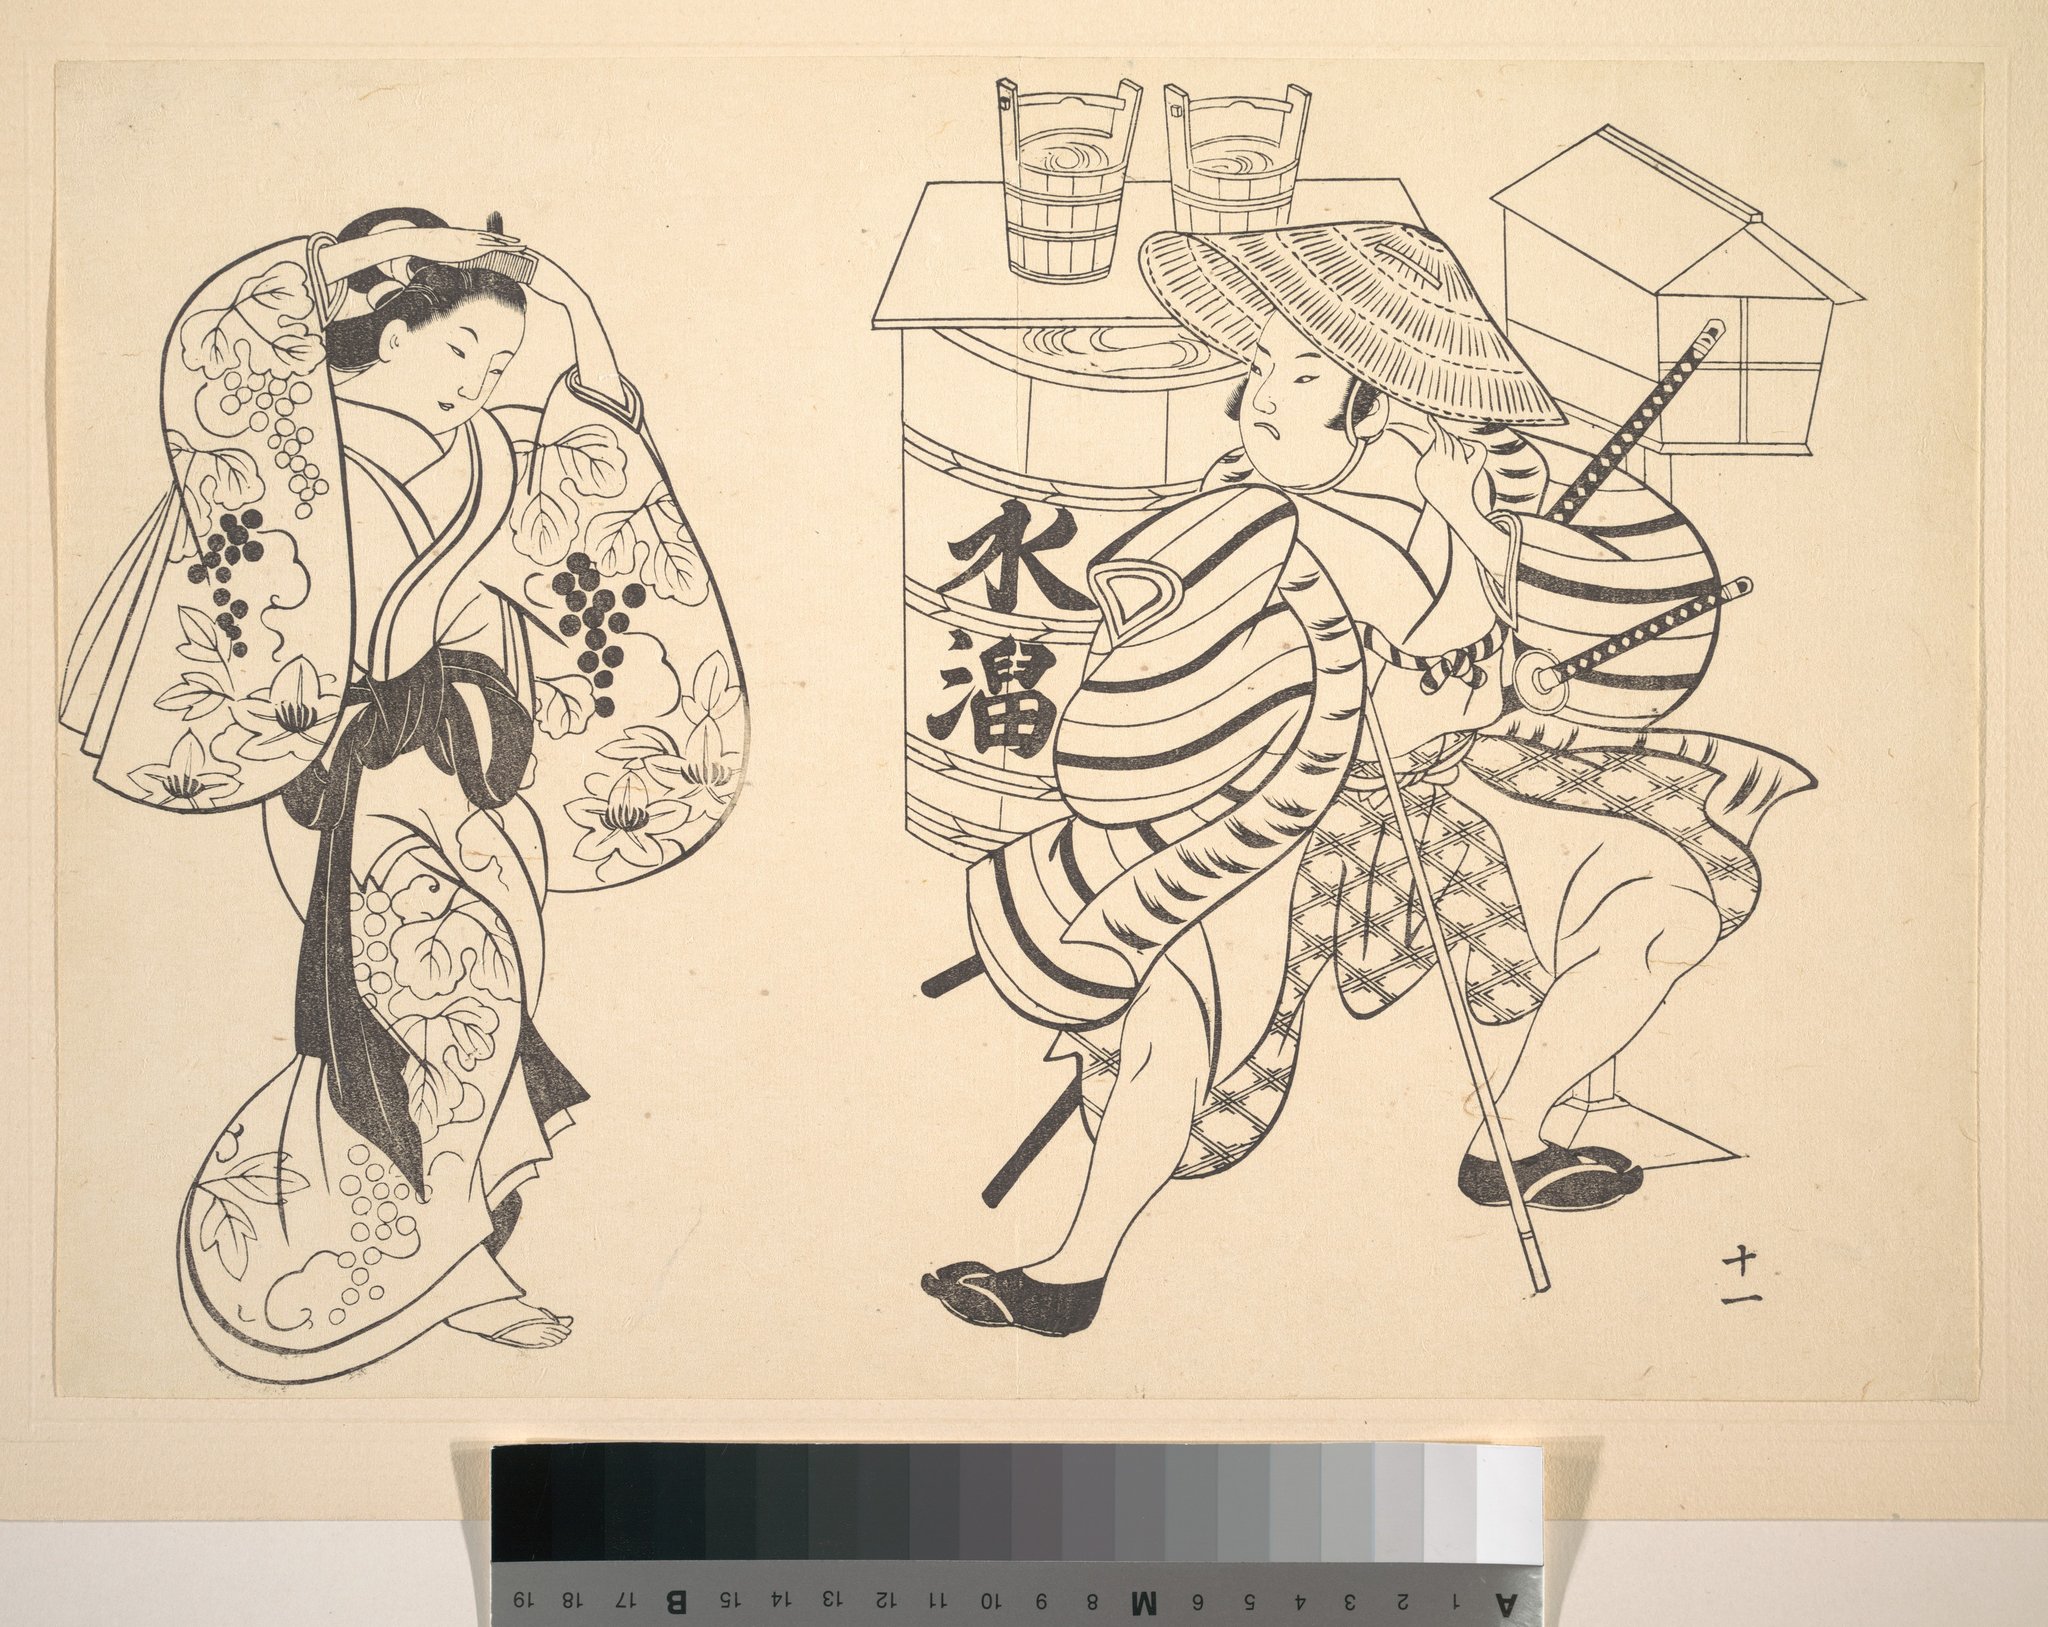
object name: print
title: An Oiran Rearranging Her Hair in the Street while a Young Samurai Looks on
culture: japanese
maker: okumura masanobu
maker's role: artist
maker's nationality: japanese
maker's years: 1686-1764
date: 1868-1912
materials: ink, paper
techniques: woodblock print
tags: hair,men,women